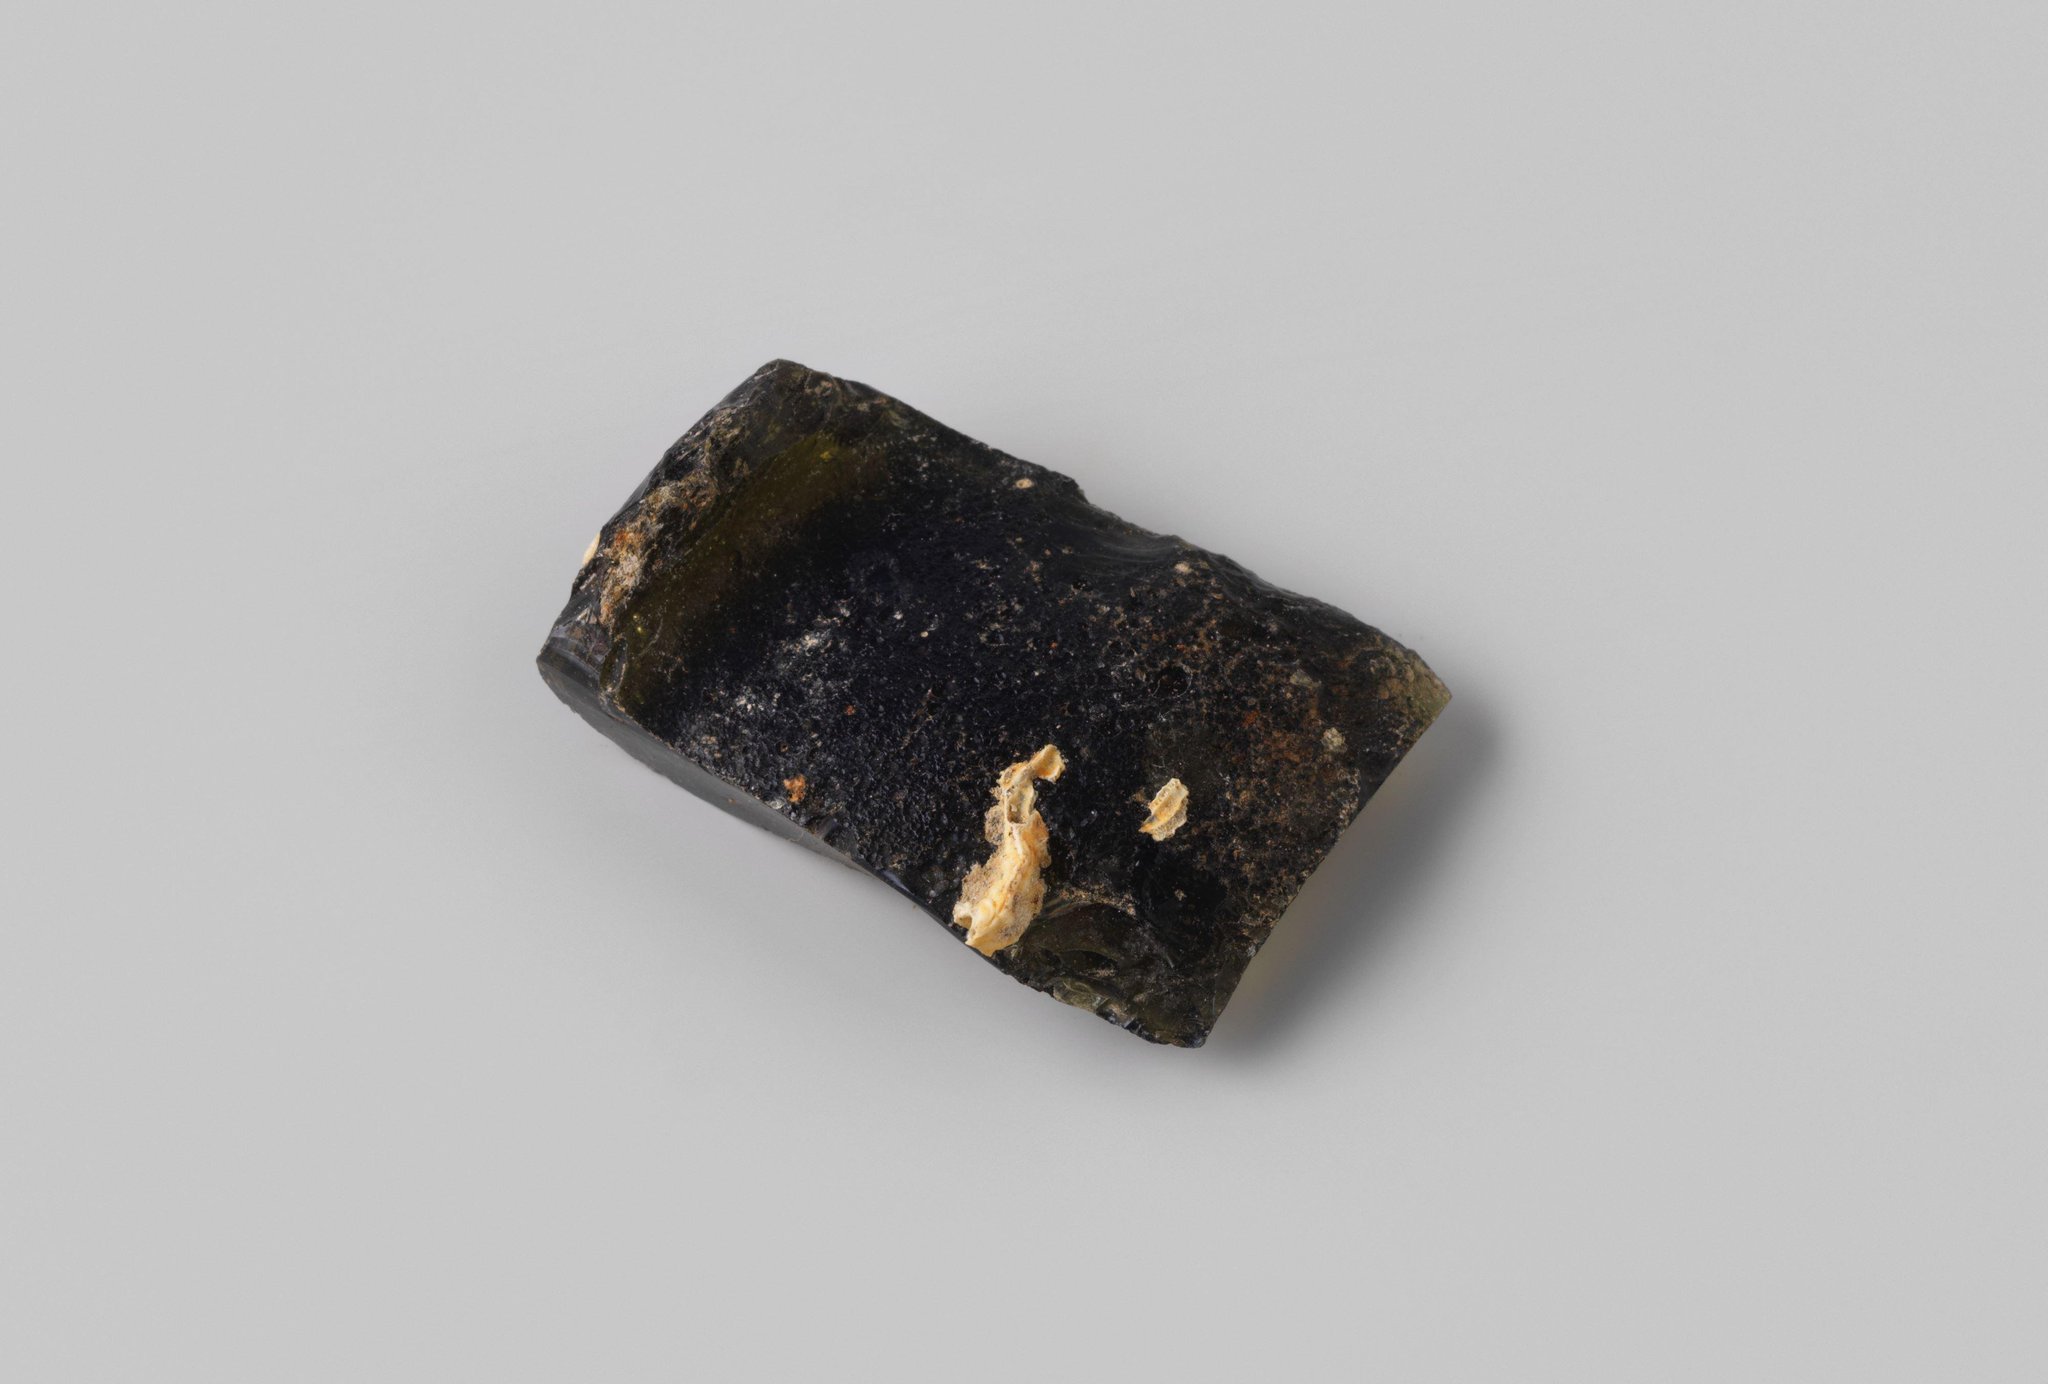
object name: wine bottle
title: Scherf van een wijnfles uit het wrak van de Oost-Indiëvaarder Hollandia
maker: Anonymous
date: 1700-1743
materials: glass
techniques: green glass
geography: netherlands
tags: verenigde oostindische compagnie, hollandia (schip), annet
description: Typologically not identifiable, base, fragm.